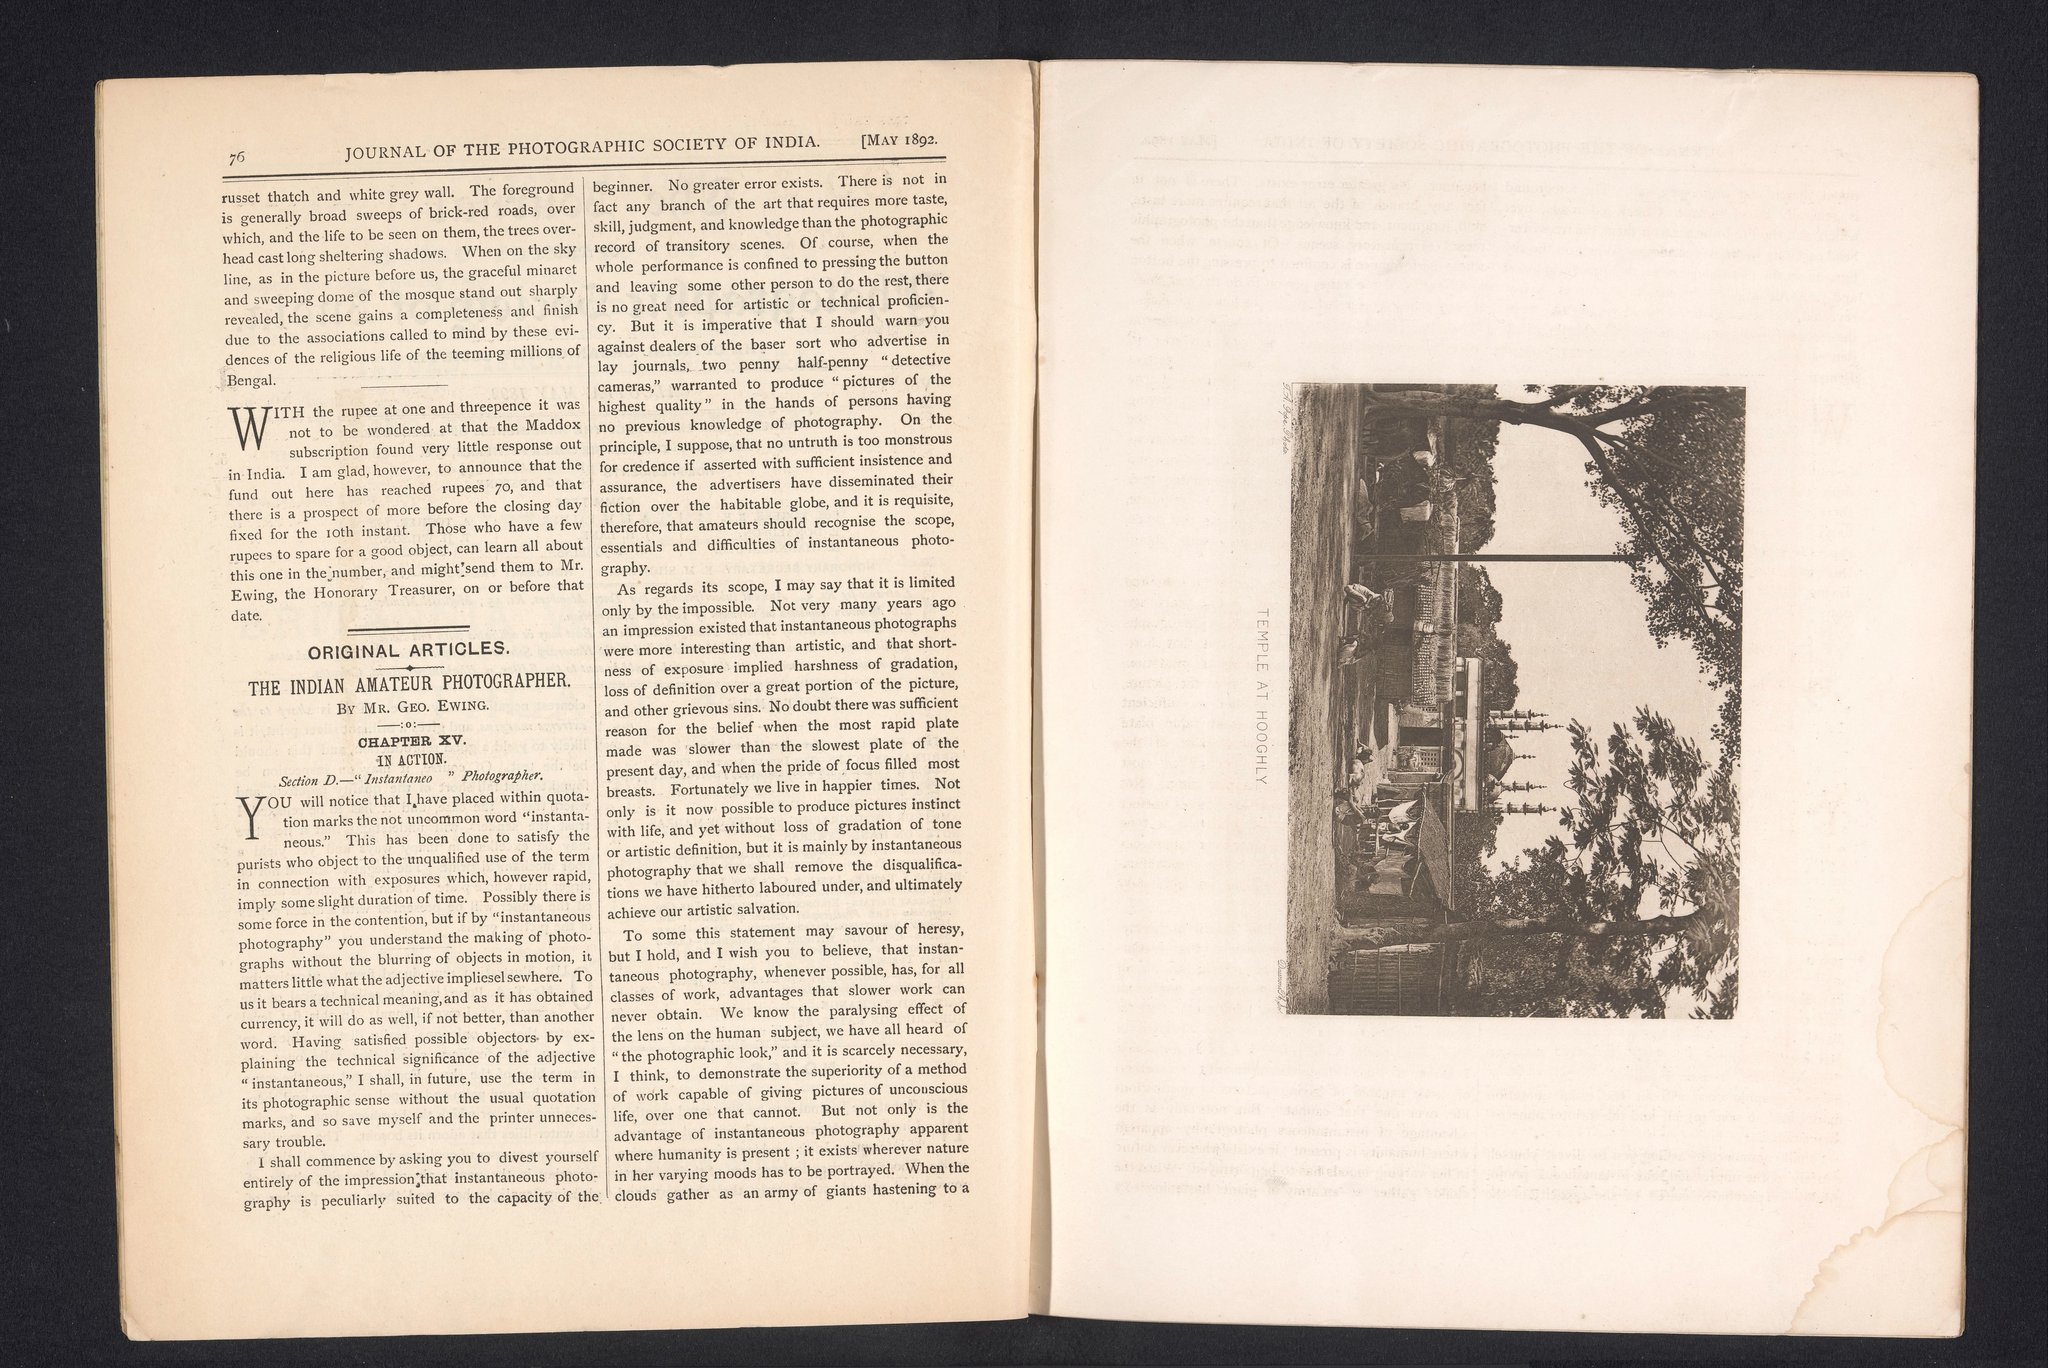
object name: page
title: Temple at Hooghly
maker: t.a. pope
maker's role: fotograaf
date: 1892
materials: paper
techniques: photoaquatint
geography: india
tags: temple, shrine ~ islam, mohammedanism